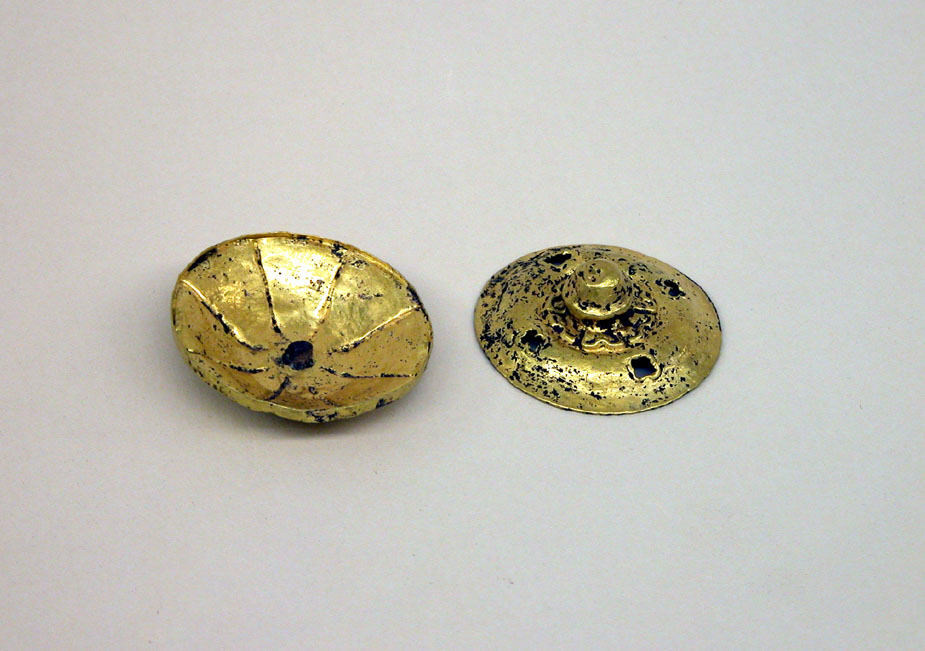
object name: incense burner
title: Round Incense Burner and Cover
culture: indonesian, javanese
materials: gold